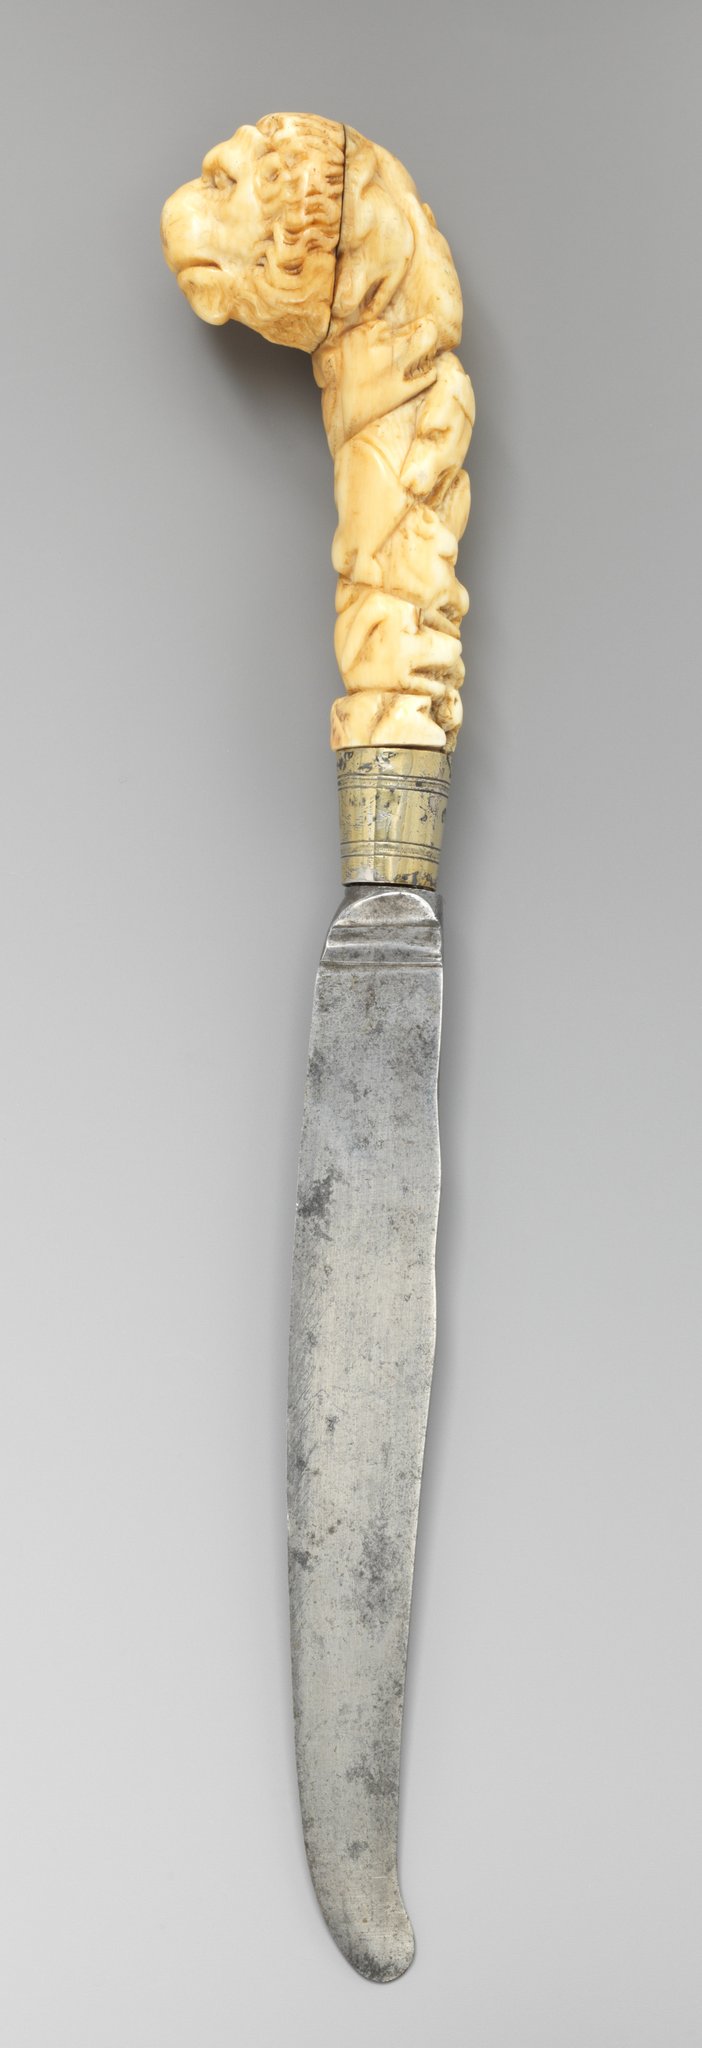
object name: table knife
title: Table knife with handle carved with lion's head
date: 1601-1700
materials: brass, ivory, steel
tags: lions